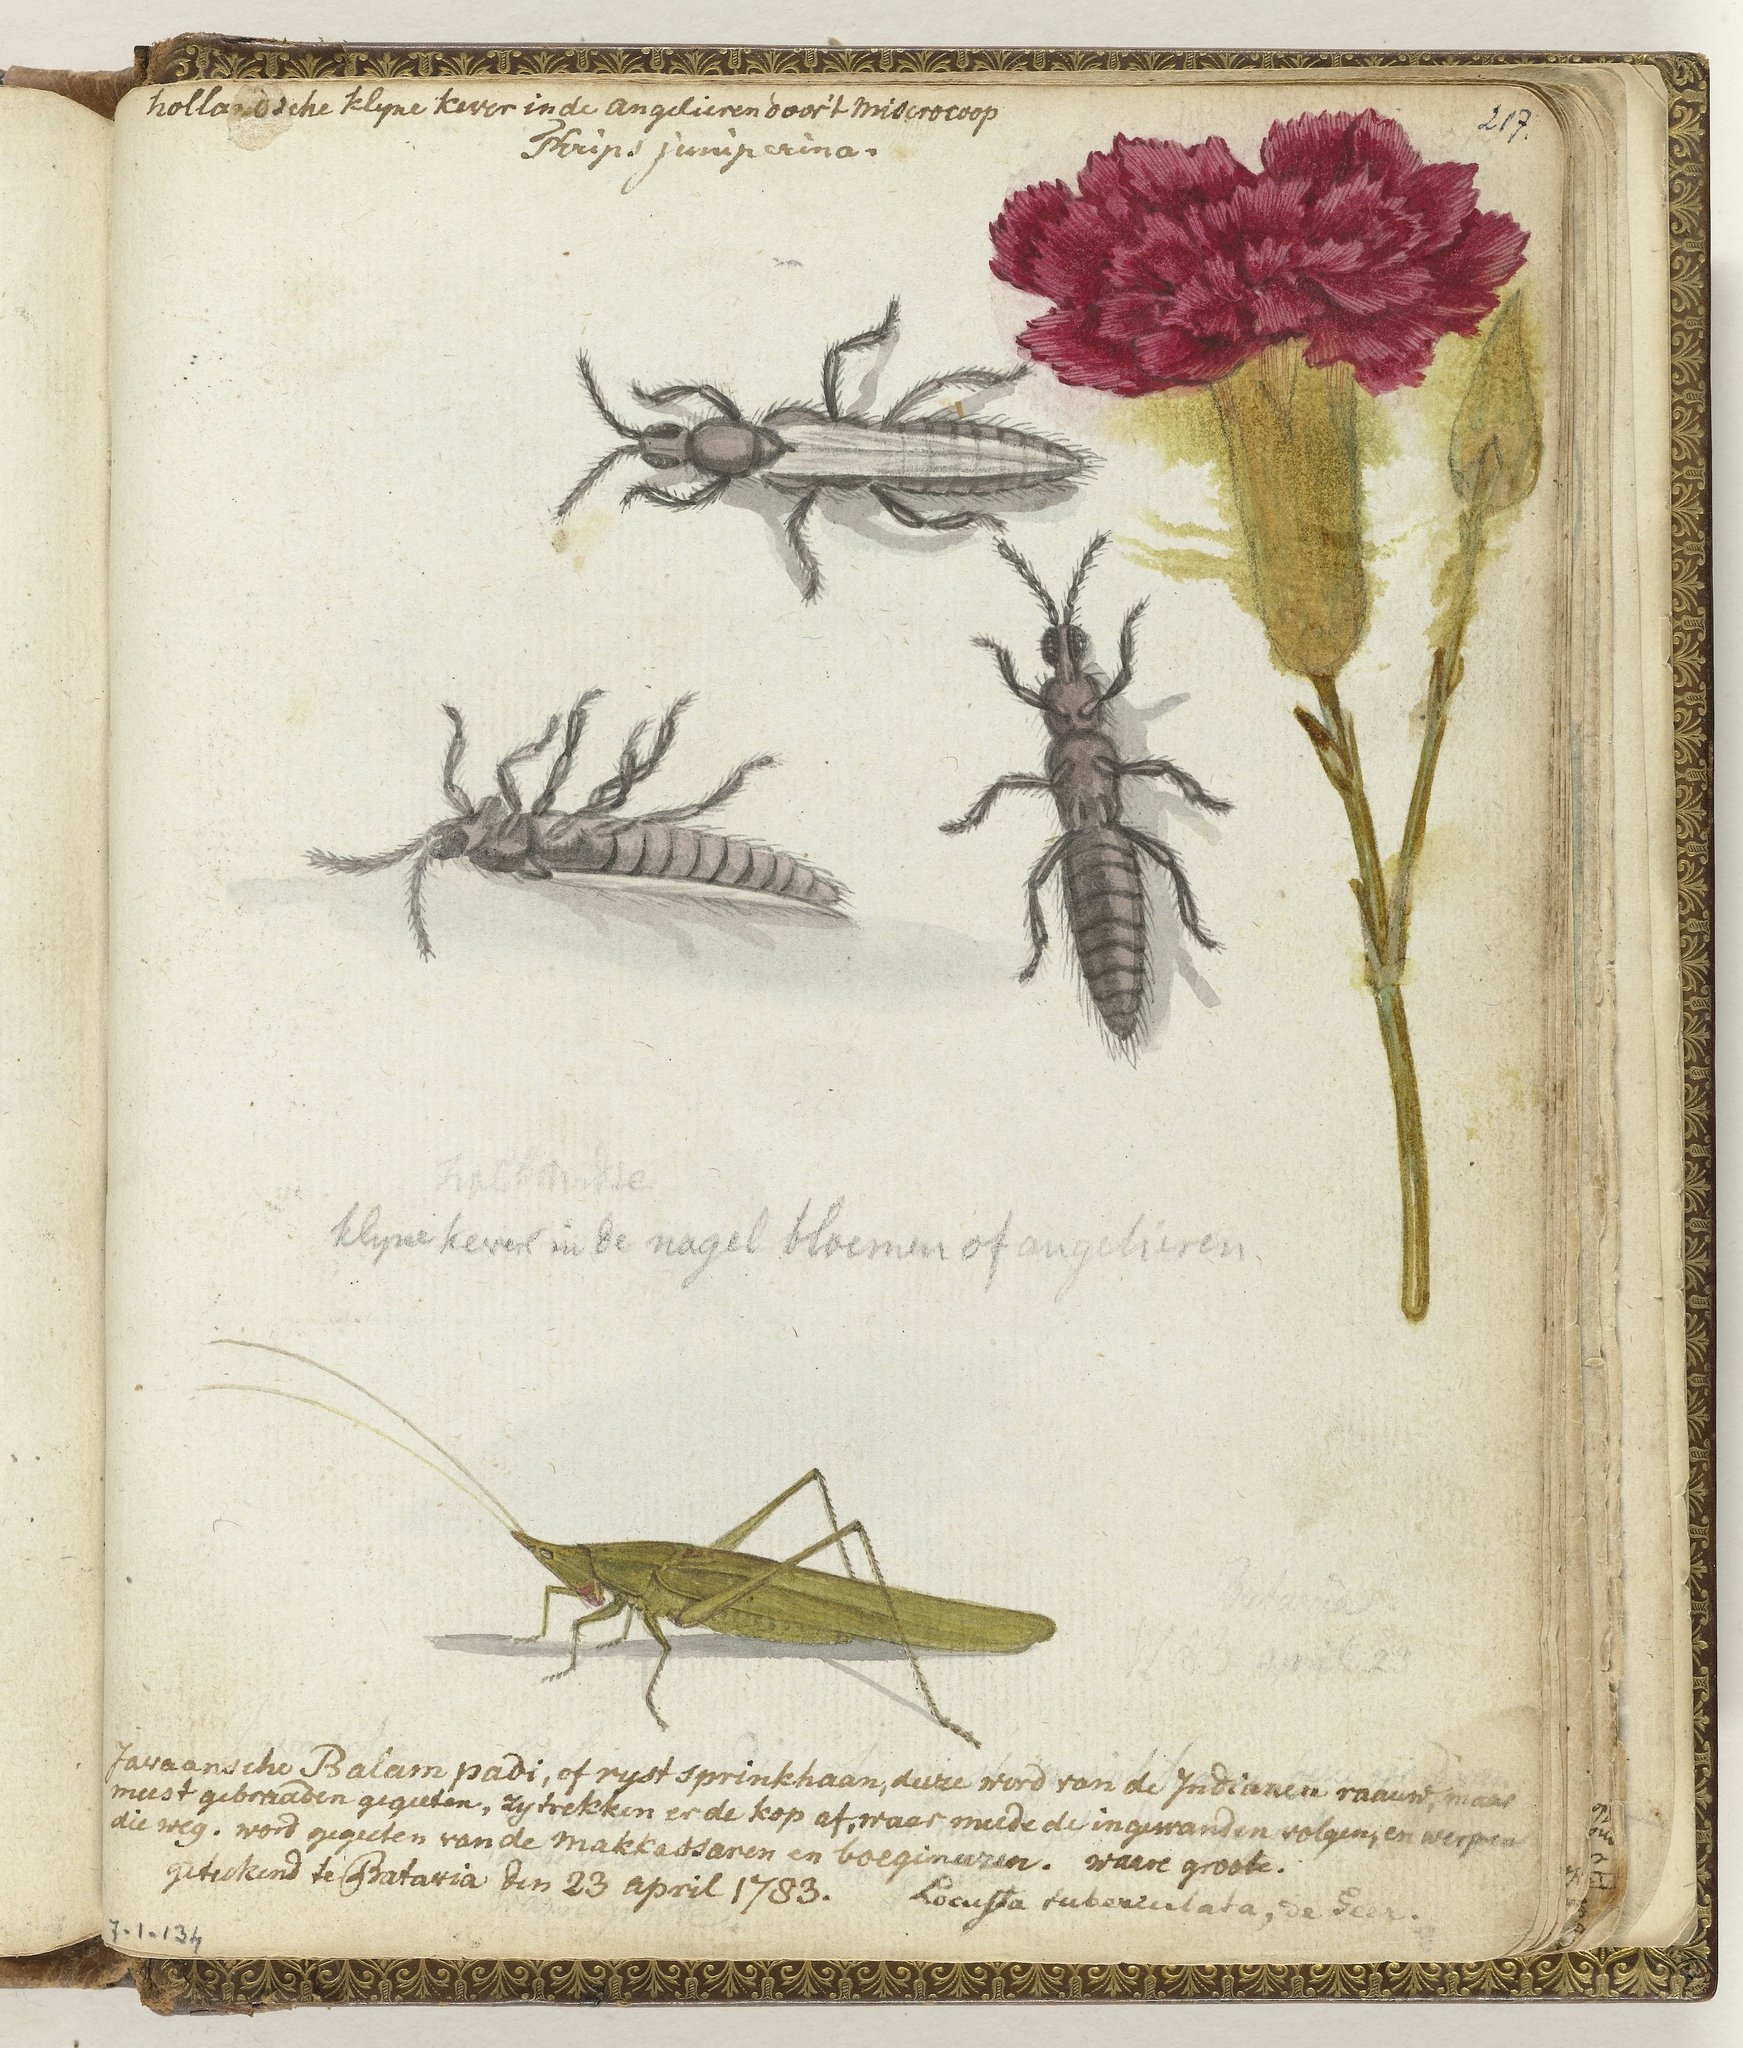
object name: drawing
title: Hollandse kever en Javaanse rijstsprinkhaan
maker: jan brandes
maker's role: draughtsman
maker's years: 1743-1808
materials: paper, pencil, watercolor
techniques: brush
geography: jakarta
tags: flowers: carnation, insects, insects: grass-hopper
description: Kleurtekening van een Hollandse kever en de anjer waarin hij door de tekenaar is gevonden. Door een microscoop getekend. Verder een Javaanse rijstsprinkhaan op ware grootte. Met opschrift. Onderdeel uit het schetsboek van Jan Brandes, dl. 1 (1808), p. 217.